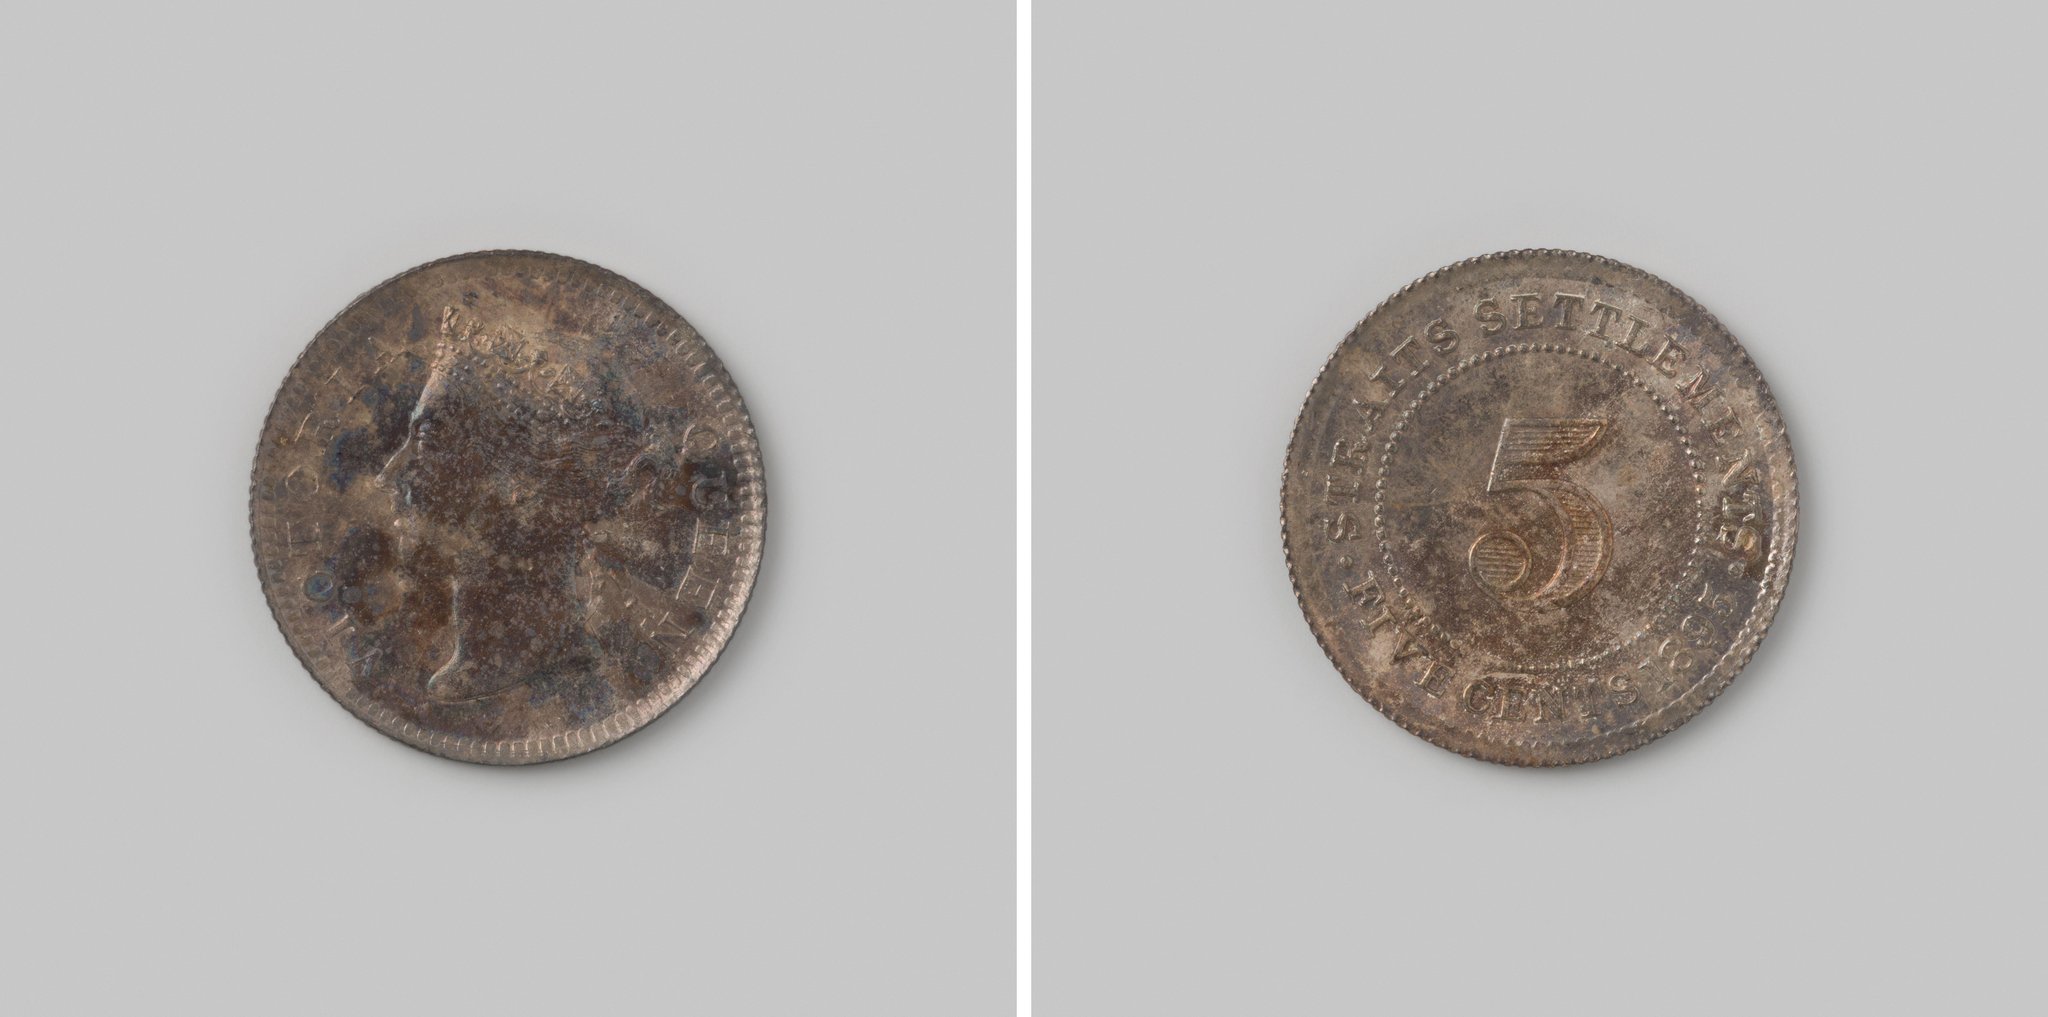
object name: coin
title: Straits Settlements, koningin Victoria, 5 cents, 1895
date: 1895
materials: silver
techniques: striking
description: Zilveren munt. Voorzijde: gekroond hoofd van koningin Victoria naar links. Keerzijde: binnen parelcirkel waarde-aanduiding: 5. In omschrift onderaan waarde-aanduiding: five cents met rechts daarvan jaartal. Kartelrand.